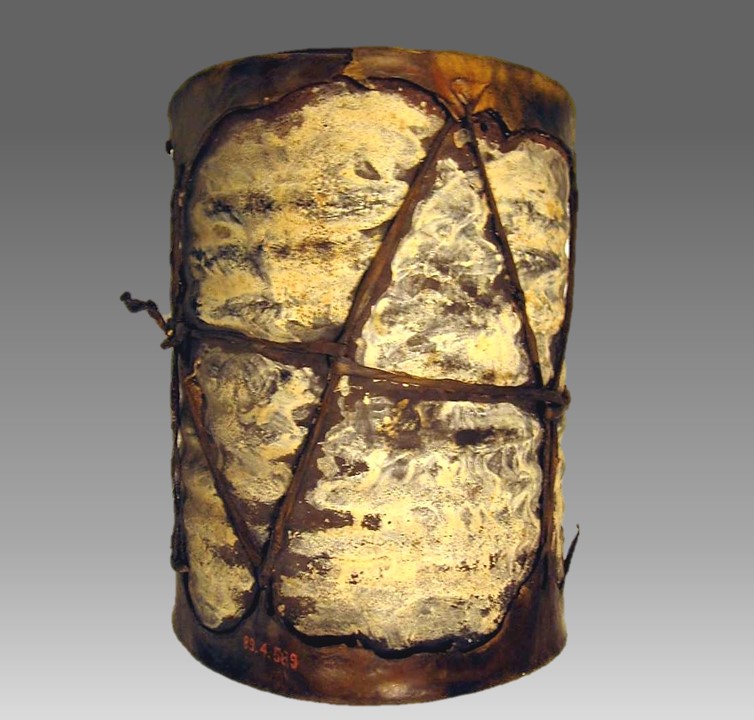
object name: drum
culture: native american, hopi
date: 1801-1900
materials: metal, skin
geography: united states